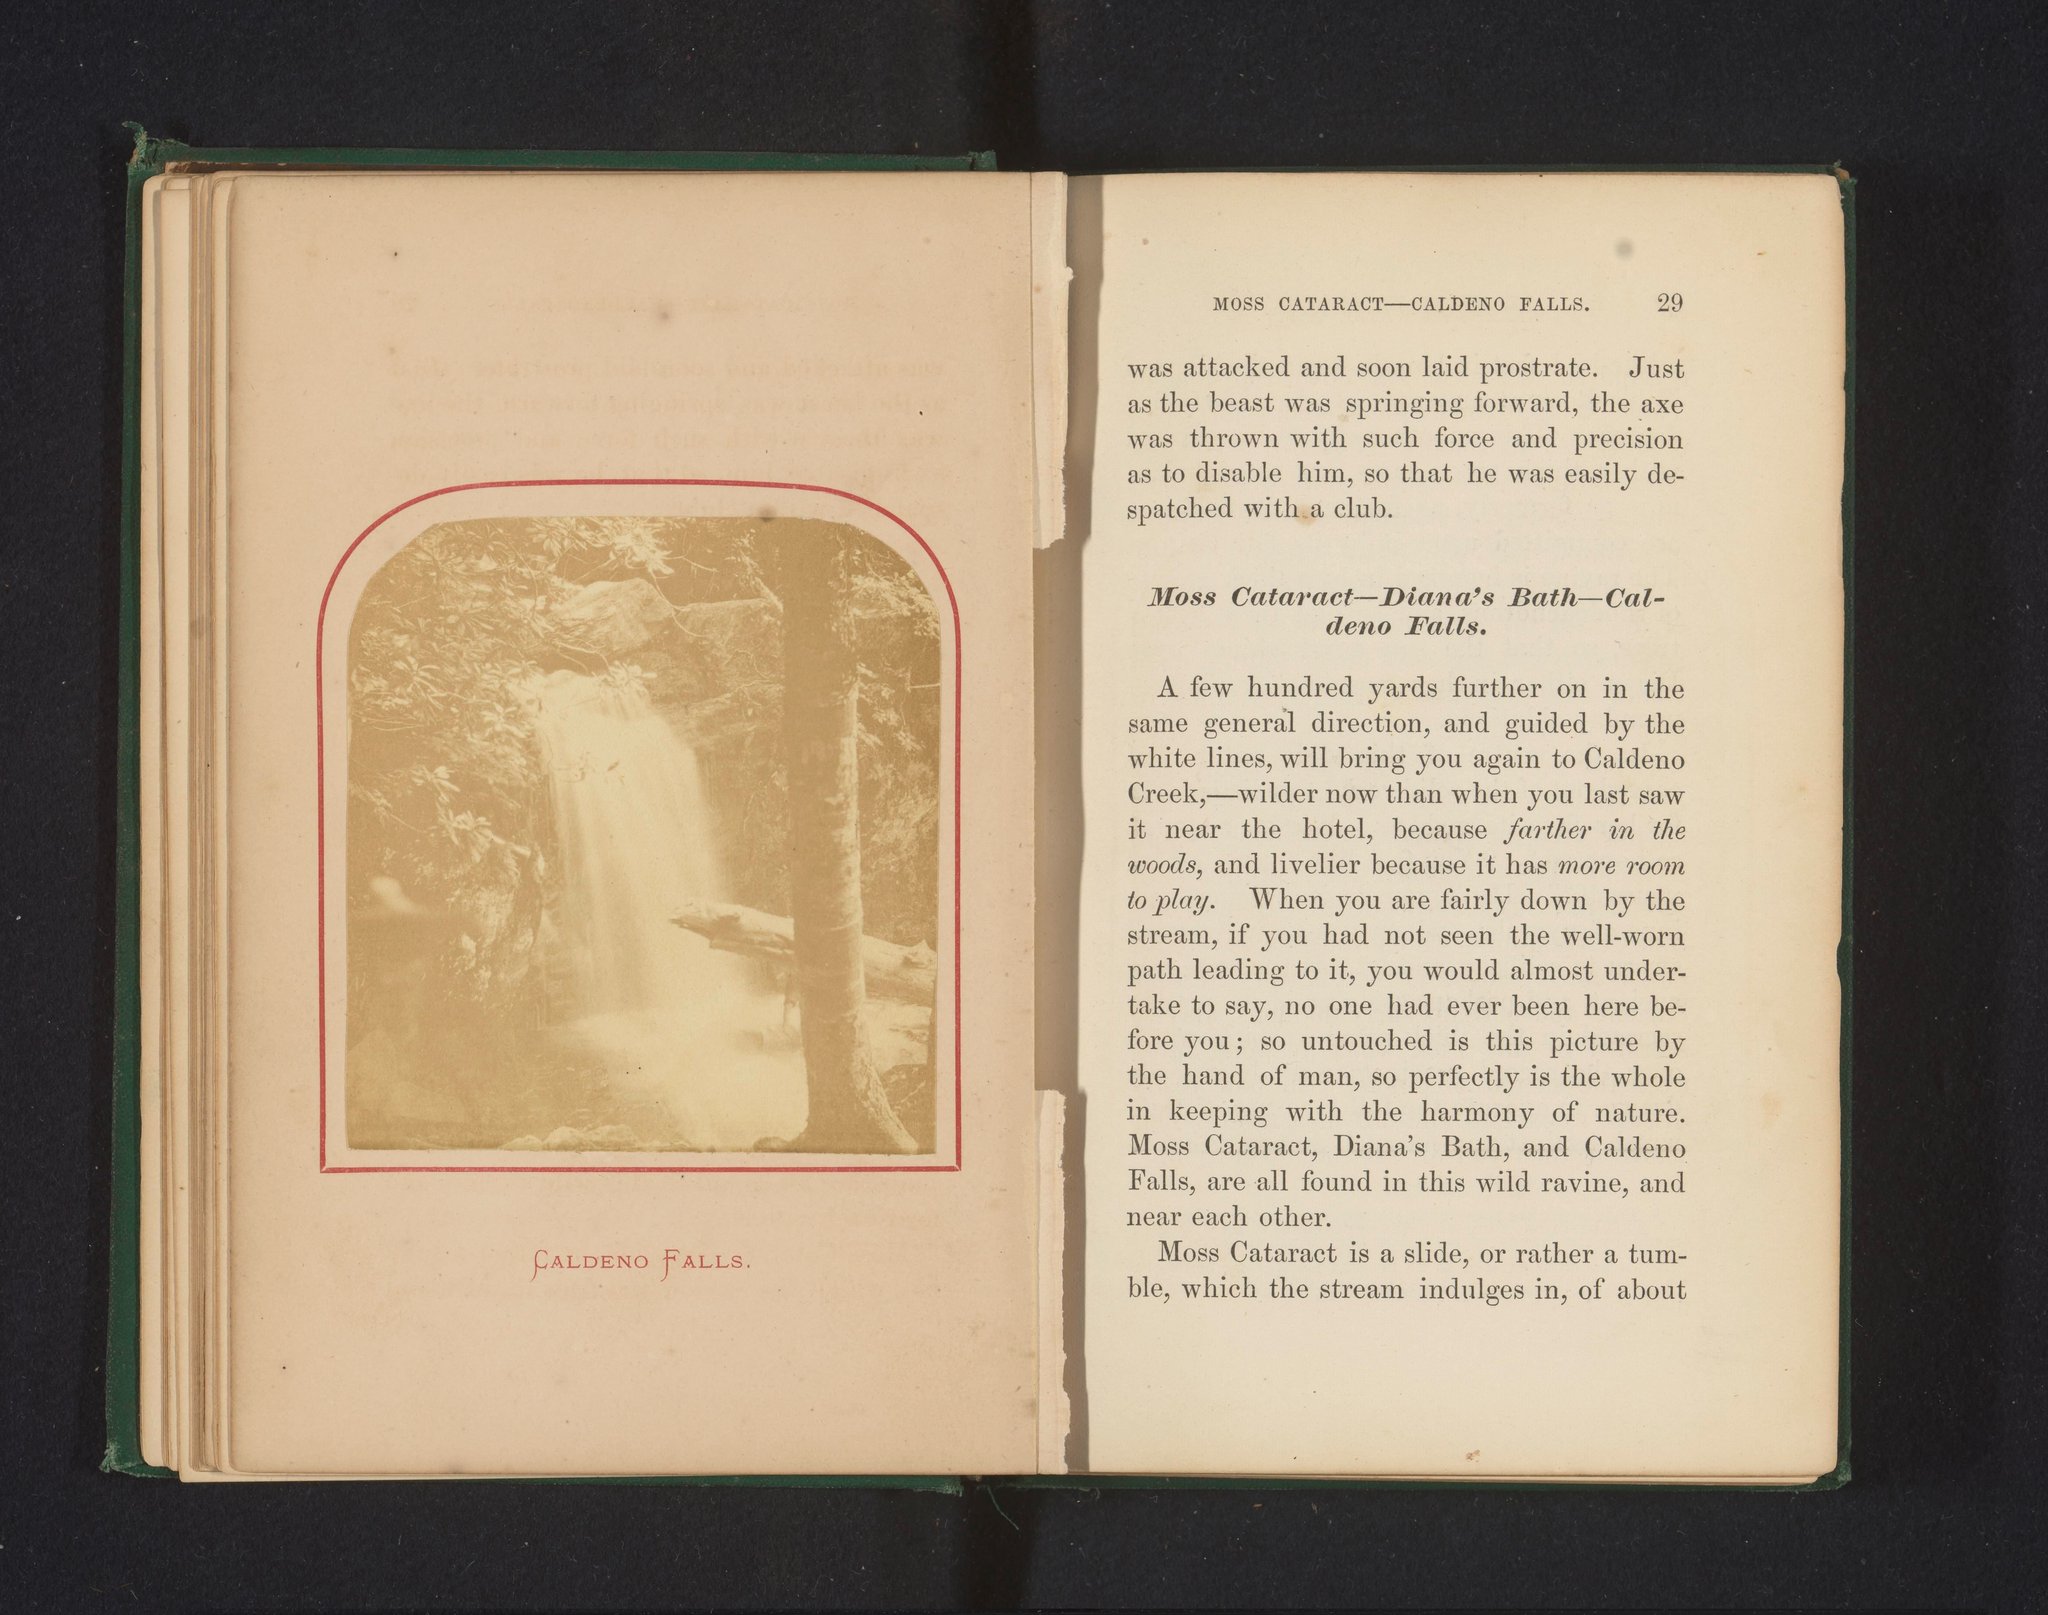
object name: page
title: Gezicht op een waterval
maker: jesse a. graves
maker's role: fotograaf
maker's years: 1835-1895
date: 1862-1867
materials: photographic support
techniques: albumen print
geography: delaware water gap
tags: waterfall, forest, wood